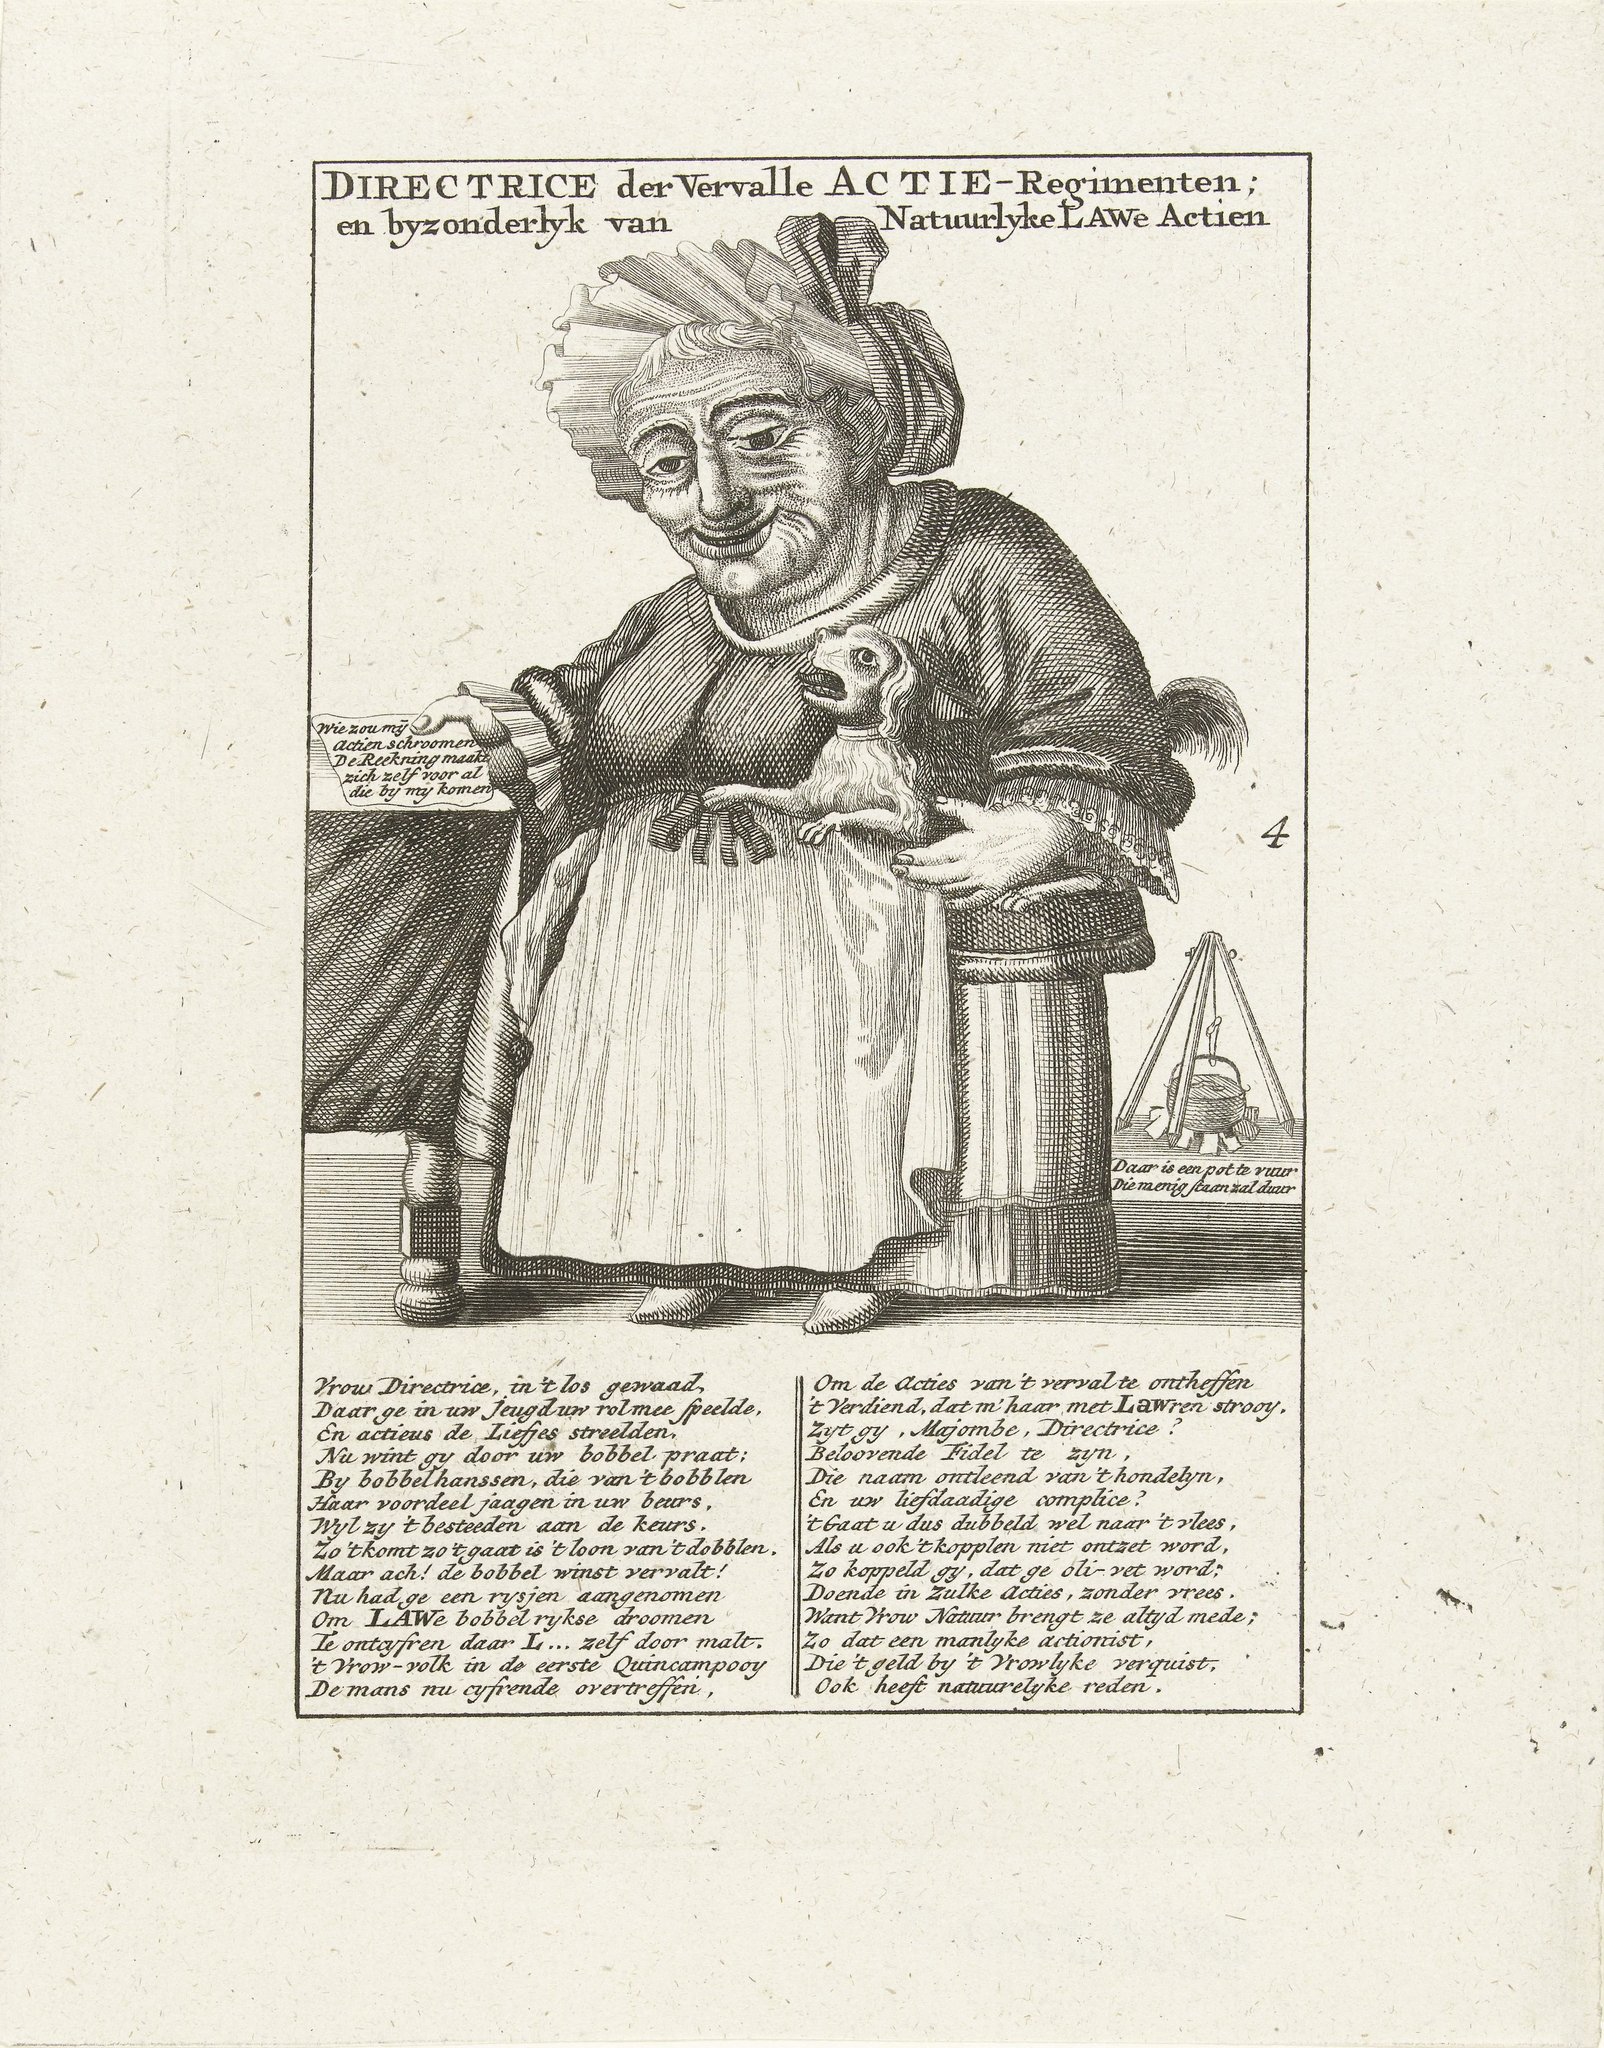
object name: cartoon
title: Karikatuur van kleine mens en de windhandel, 1720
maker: Anonymous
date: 1770-1780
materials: paper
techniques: engraving, etching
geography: northern netherlands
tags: caricatures (human types), little people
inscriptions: collector's mark: Lugt 2228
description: Een kleine mens als een oude vrouw met een hondje op de arm, met onderschrift in twee kolommen. Genummerd 4. Gedrukt van een grote plaat waarop alle vier voorstellingen genummerd 1-4 zijn geëtst. Prent 26/4 in de serie Het Groote Tafereel der Dwaasheid met spotprenten op de Windhandel of Actiehandel van 1720.